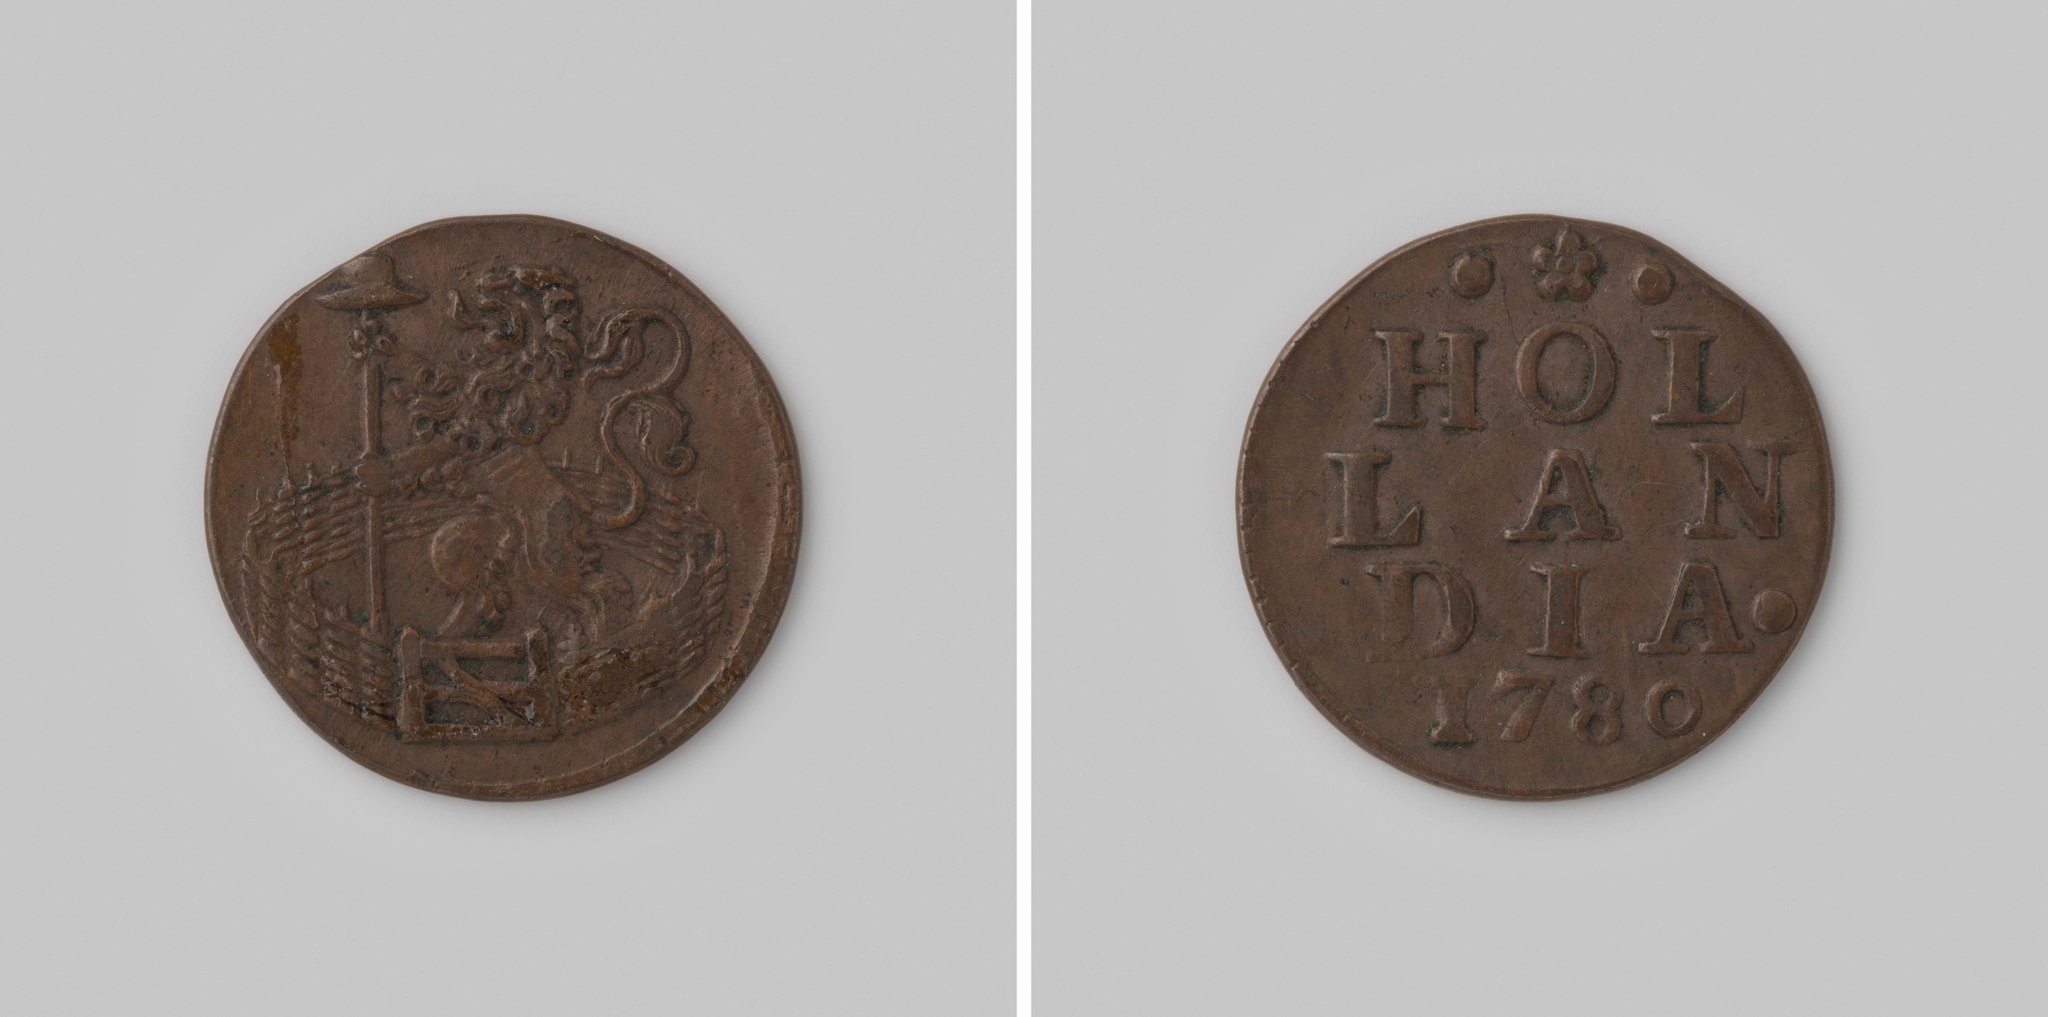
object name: coin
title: Hollandse duit, 1780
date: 1780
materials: copper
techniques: striking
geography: dordrecht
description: Koperen munt. Voorzijde: binnen omheining staande leeuw met vrijheidshoed op speer. Keerzijde: opschrift: provincienaam in drie regels, daaronder jaartal.